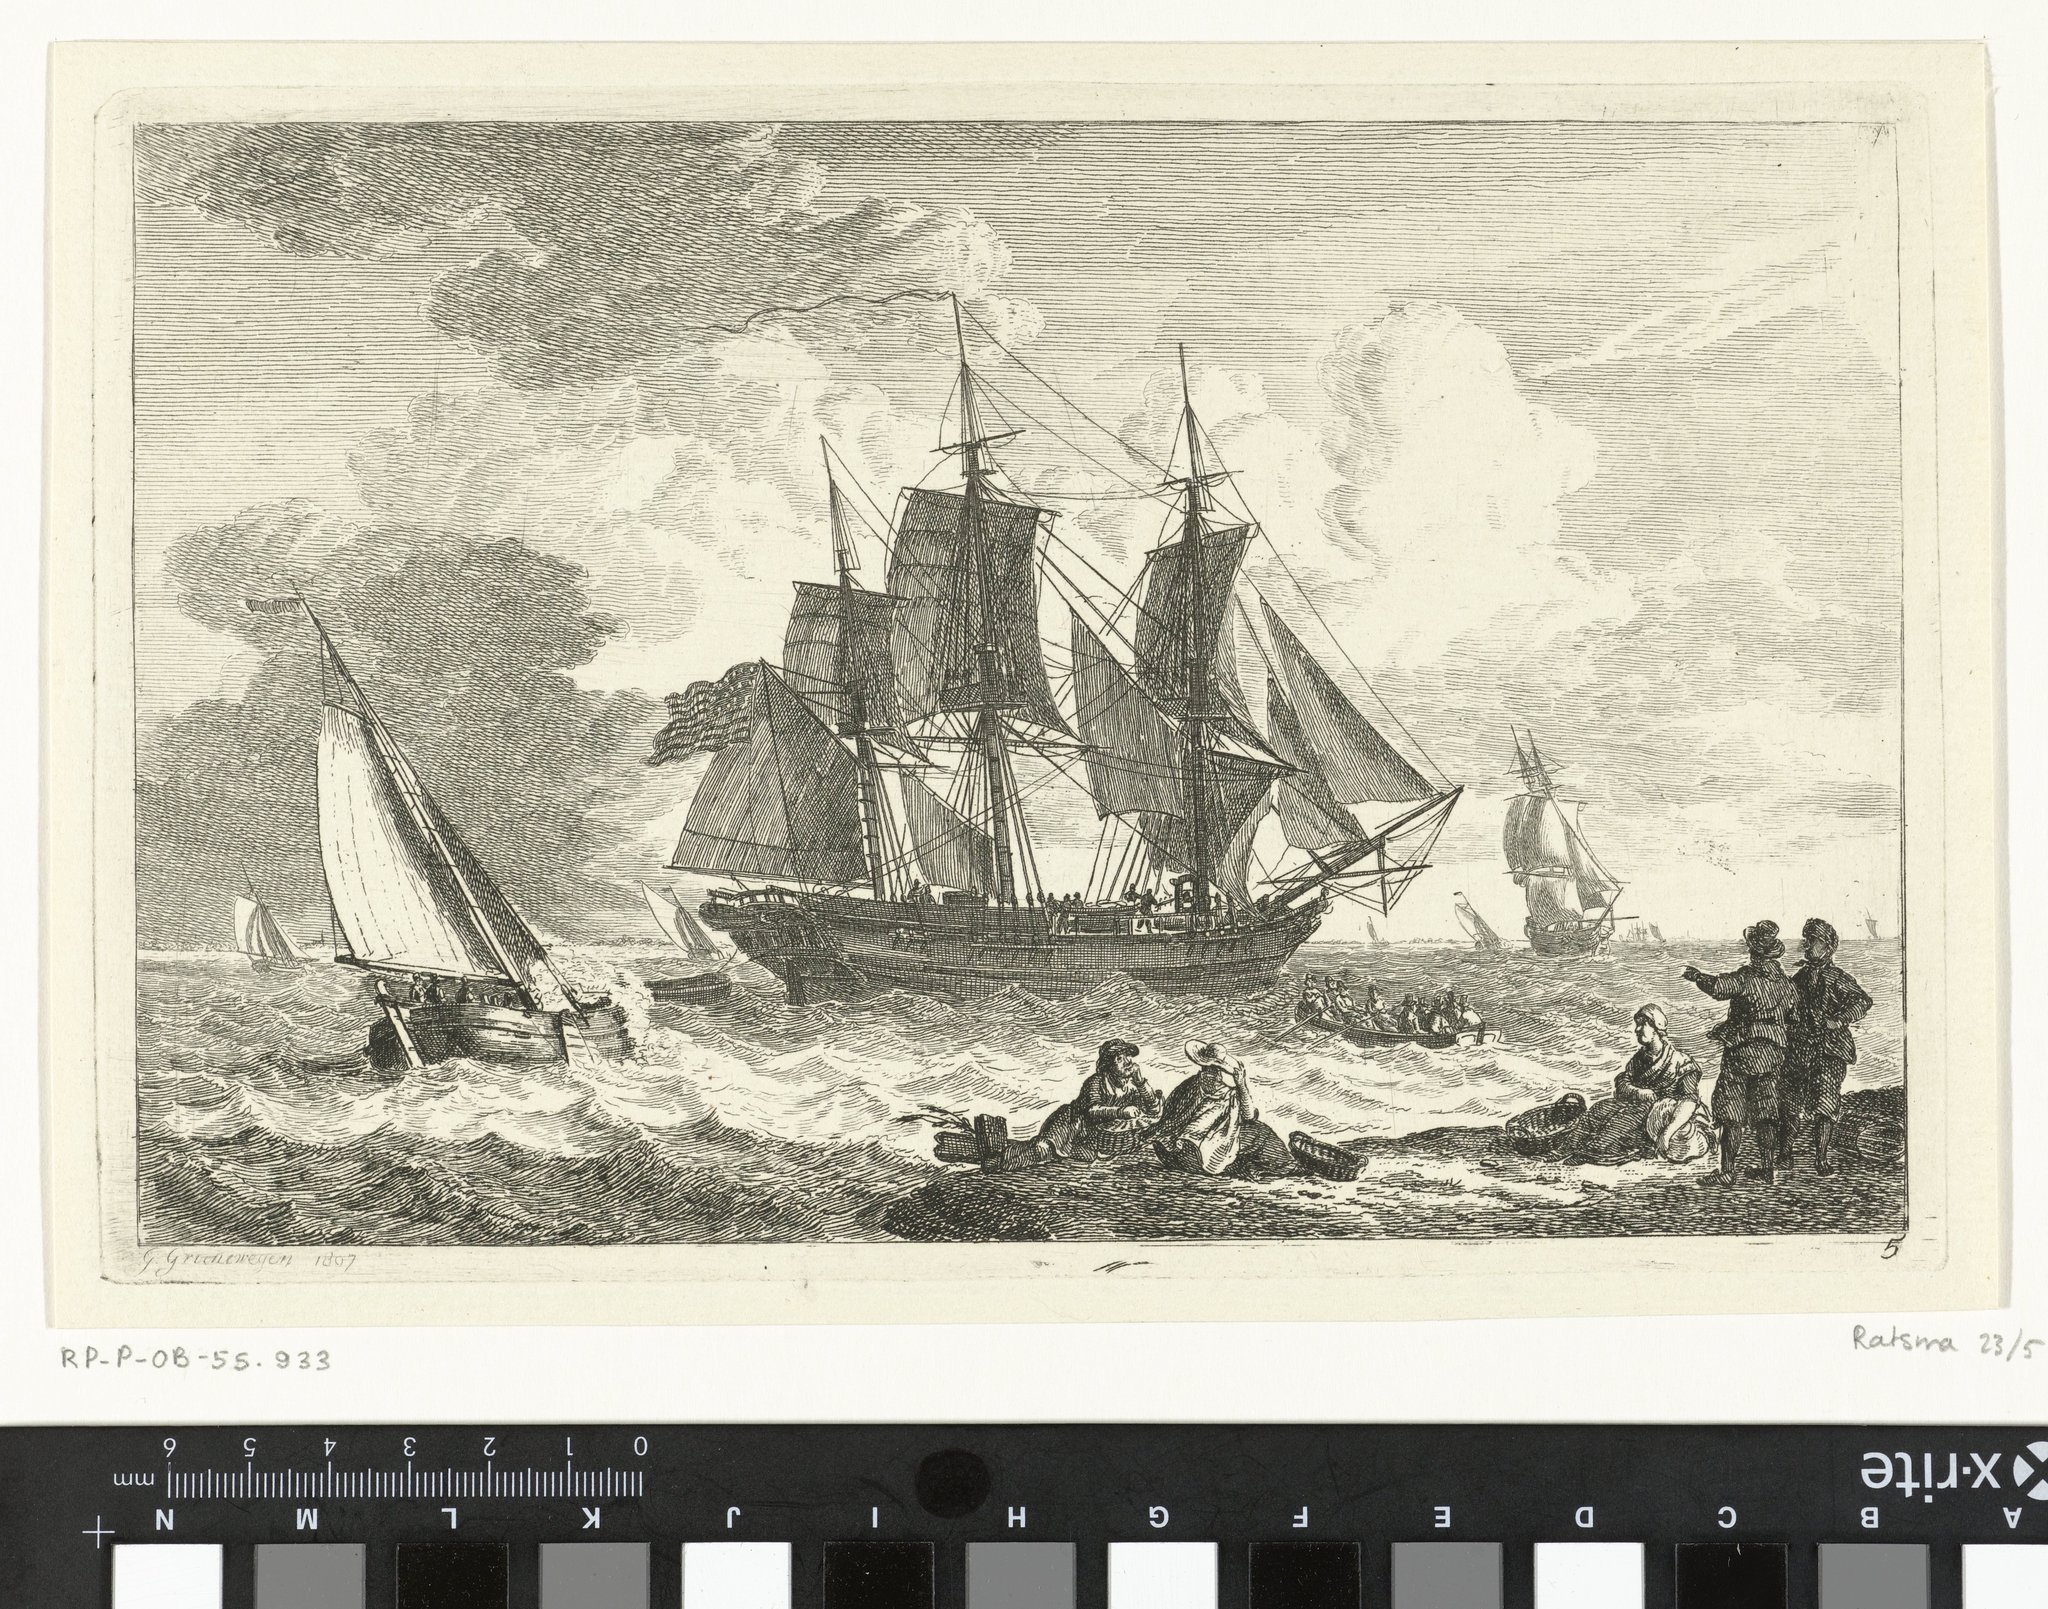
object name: print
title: Diverse schepen op het water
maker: gerrit groenewegen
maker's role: draughtsman, print maker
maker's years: 1754-1826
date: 1807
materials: paper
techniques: etching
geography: rotterdam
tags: ships (in general) - cc - more than one ship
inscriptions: collector's mark: Lugt 2228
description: Verschillende schepen, waarvan er een onder de Amerikaanse vlag vaart, op onrustig water. Rechts zitten drie vrouwen met hoeden en manden op het vaste land. Naast de vrouwen staan twee mannen waarvan er een naar het Amerikaanse schip wijst. Deze prent maakt deel uit van een serie van zes prenten met diverse schepen.